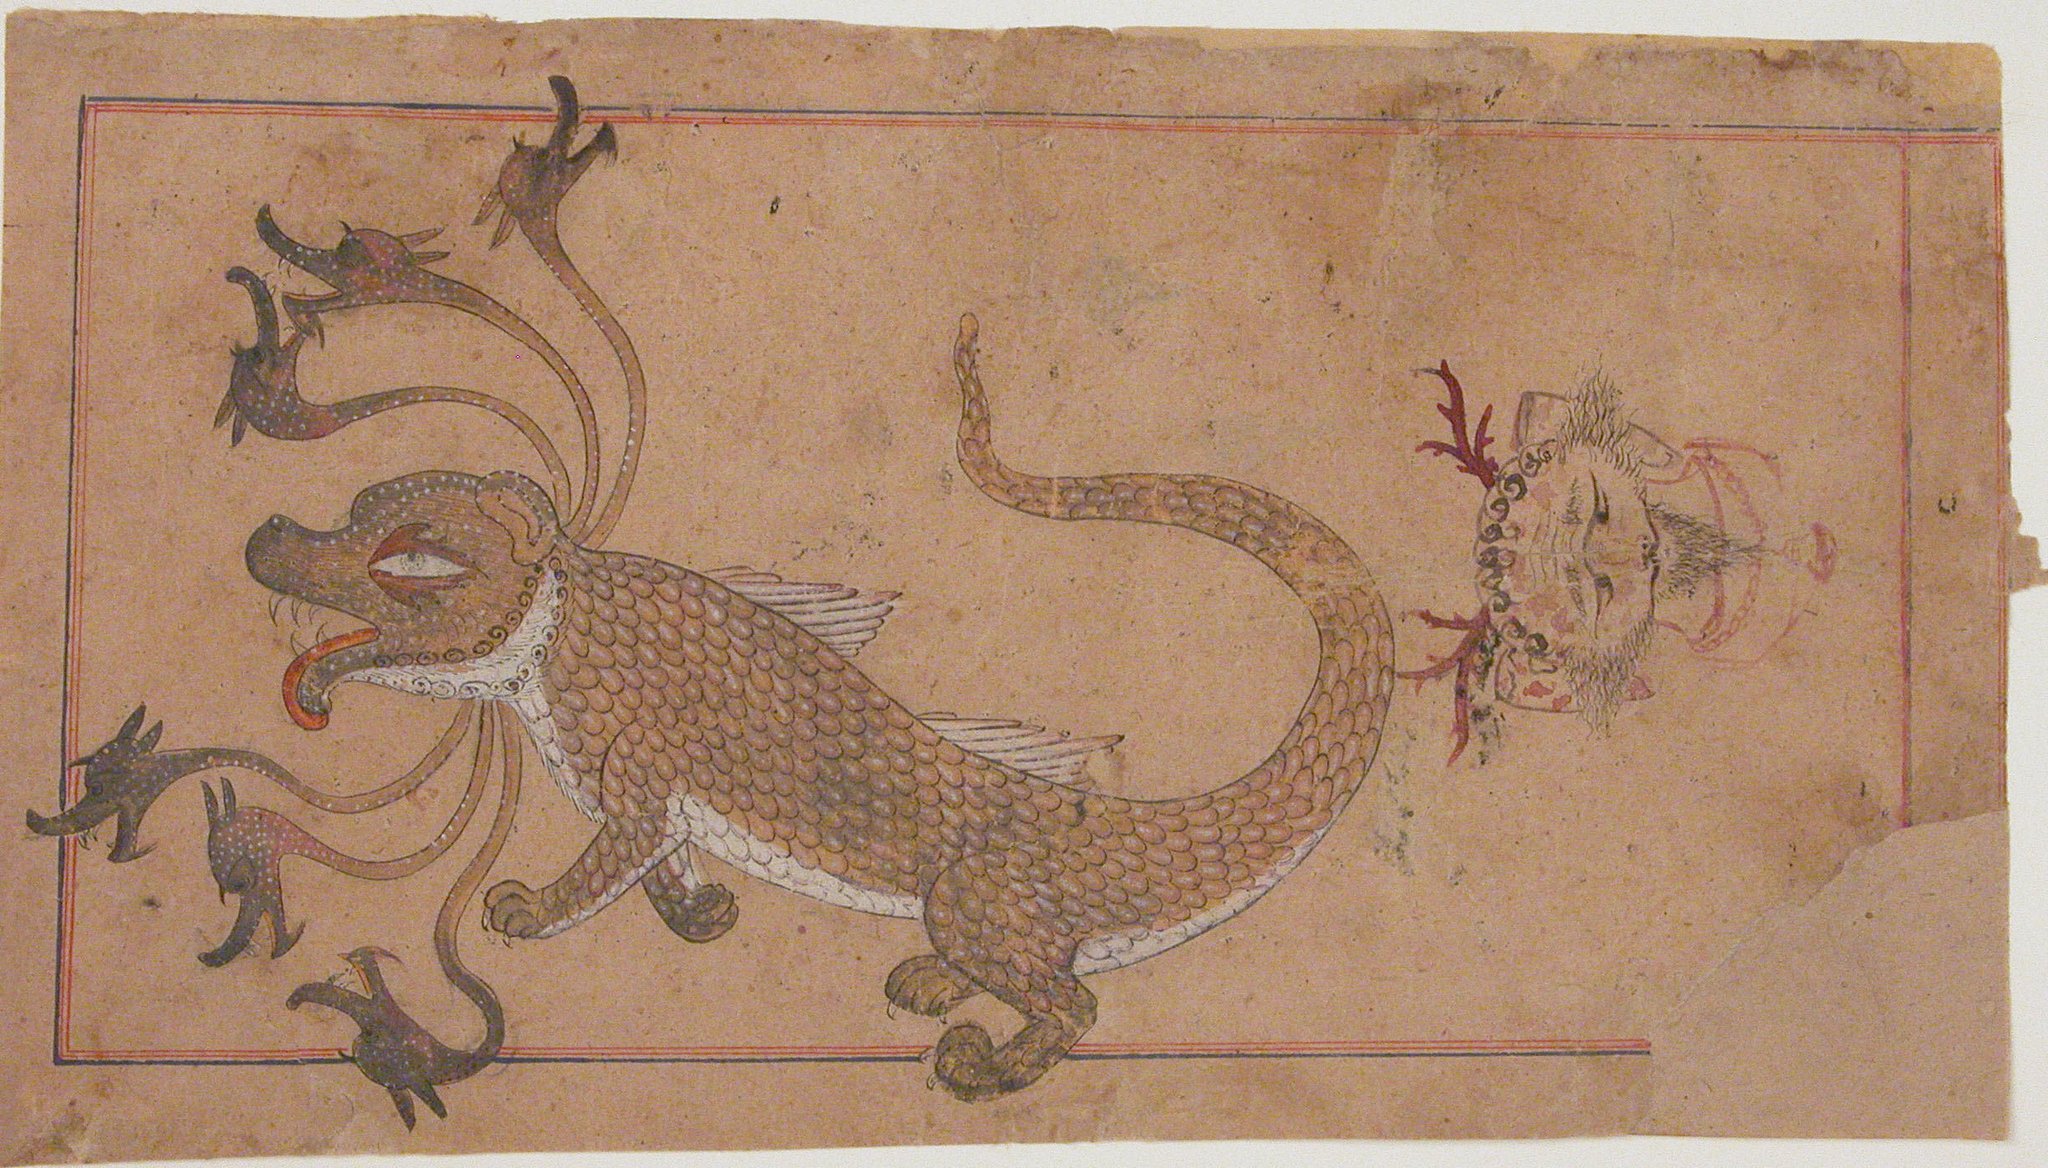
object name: illustrated single work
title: Dragon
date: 1501-1700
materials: ink, paper, watercolor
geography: iran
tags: dragons